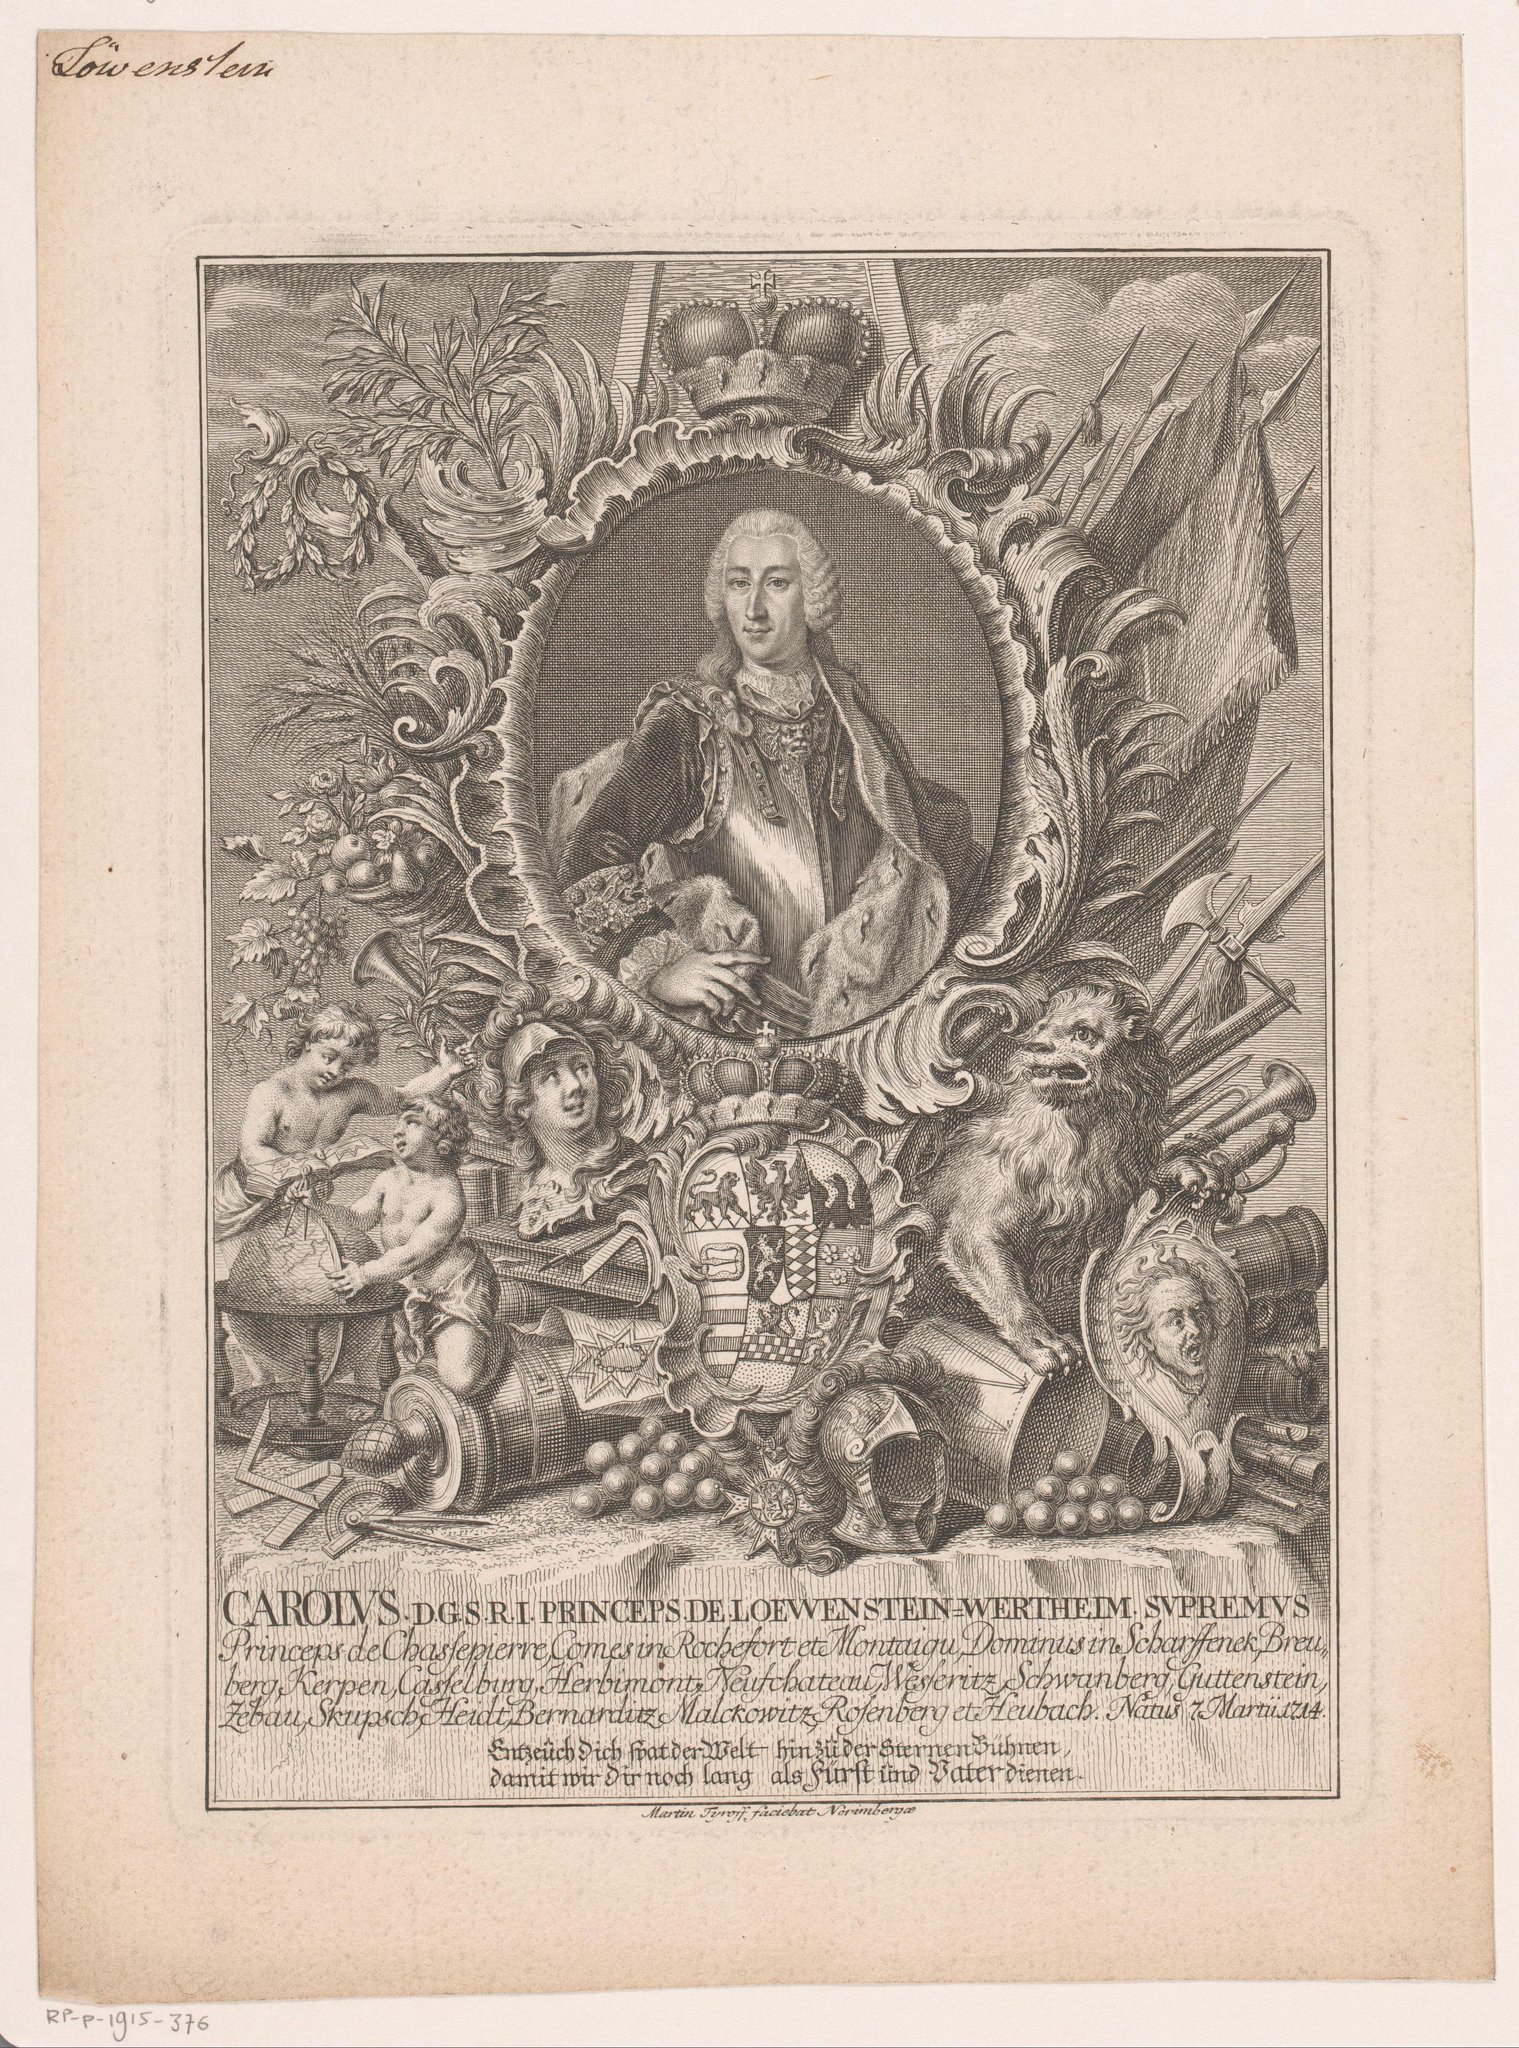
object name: print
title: Portret van Karl Thomas Löwenstein-Wertheim-Rochefort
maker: martin tyroff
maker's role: print maker, publisher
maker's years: 1704-1779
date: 1735-1779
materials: paper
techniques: engraving, etching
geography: nuremberg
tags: augsburg, musical instruments; group of musical instruments, armour, historical persons, measuring-instruments, armorial bearing, heraldry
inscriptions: collector's mark: Lugt 2228, inscription: ‘Löwenstein’